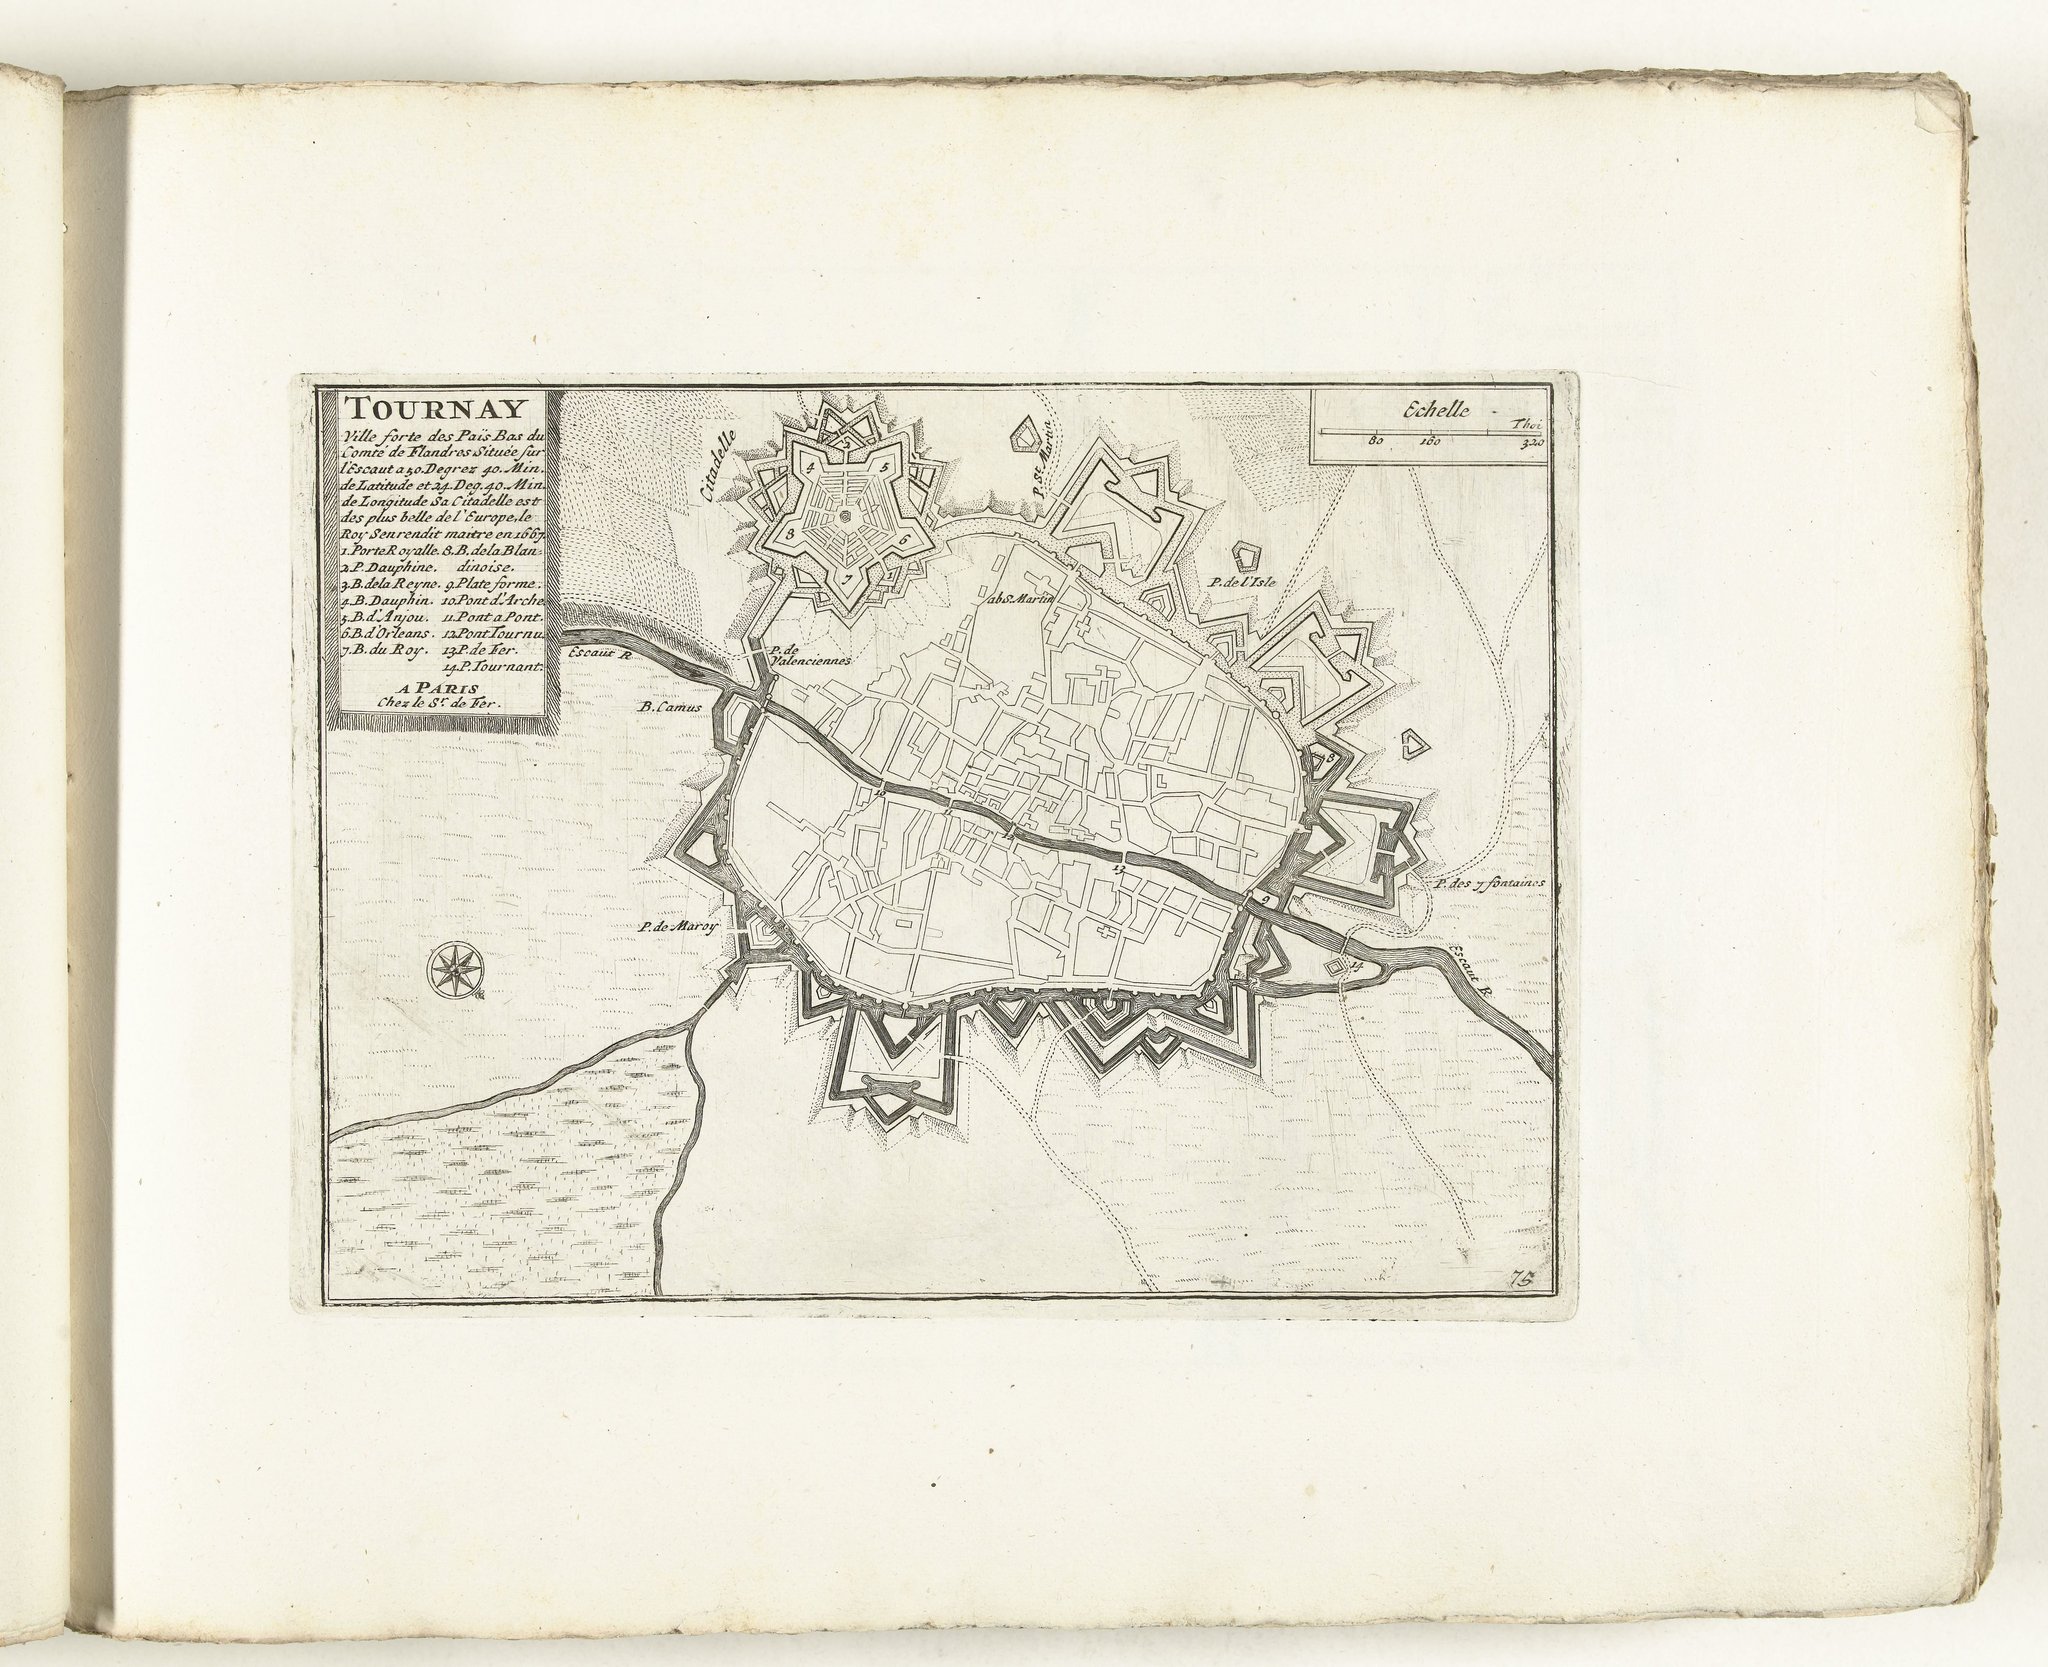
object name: map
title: Plattegrond van Tournai, ca. 1702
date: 1702-1703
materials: paper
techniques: etching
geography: paris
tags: fortress, maps of cities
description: Plattegrond van de verdedigingswerken om de stad Tournai (Doornik). Plaat nr. 75 in het prentwerk bestaande in totaal uit 276 genummerde platen van vermaarde sterke steden en vestingen in het kader van de Spaanse Successieoorlog. Voor het merendeel zijn deze platen gekopieerd naar de anonieme Franse platen: in Les forces de l'Europe en in: Le theatre de la guerre, dans les Pays-Bas, beide oorspronkelijk uitgegeven door Nicolas de Fer te Parijs (1693-1697) in het kader van de Negenjarige Oorlog. Titel en opschriften in de plaat in het Frans.